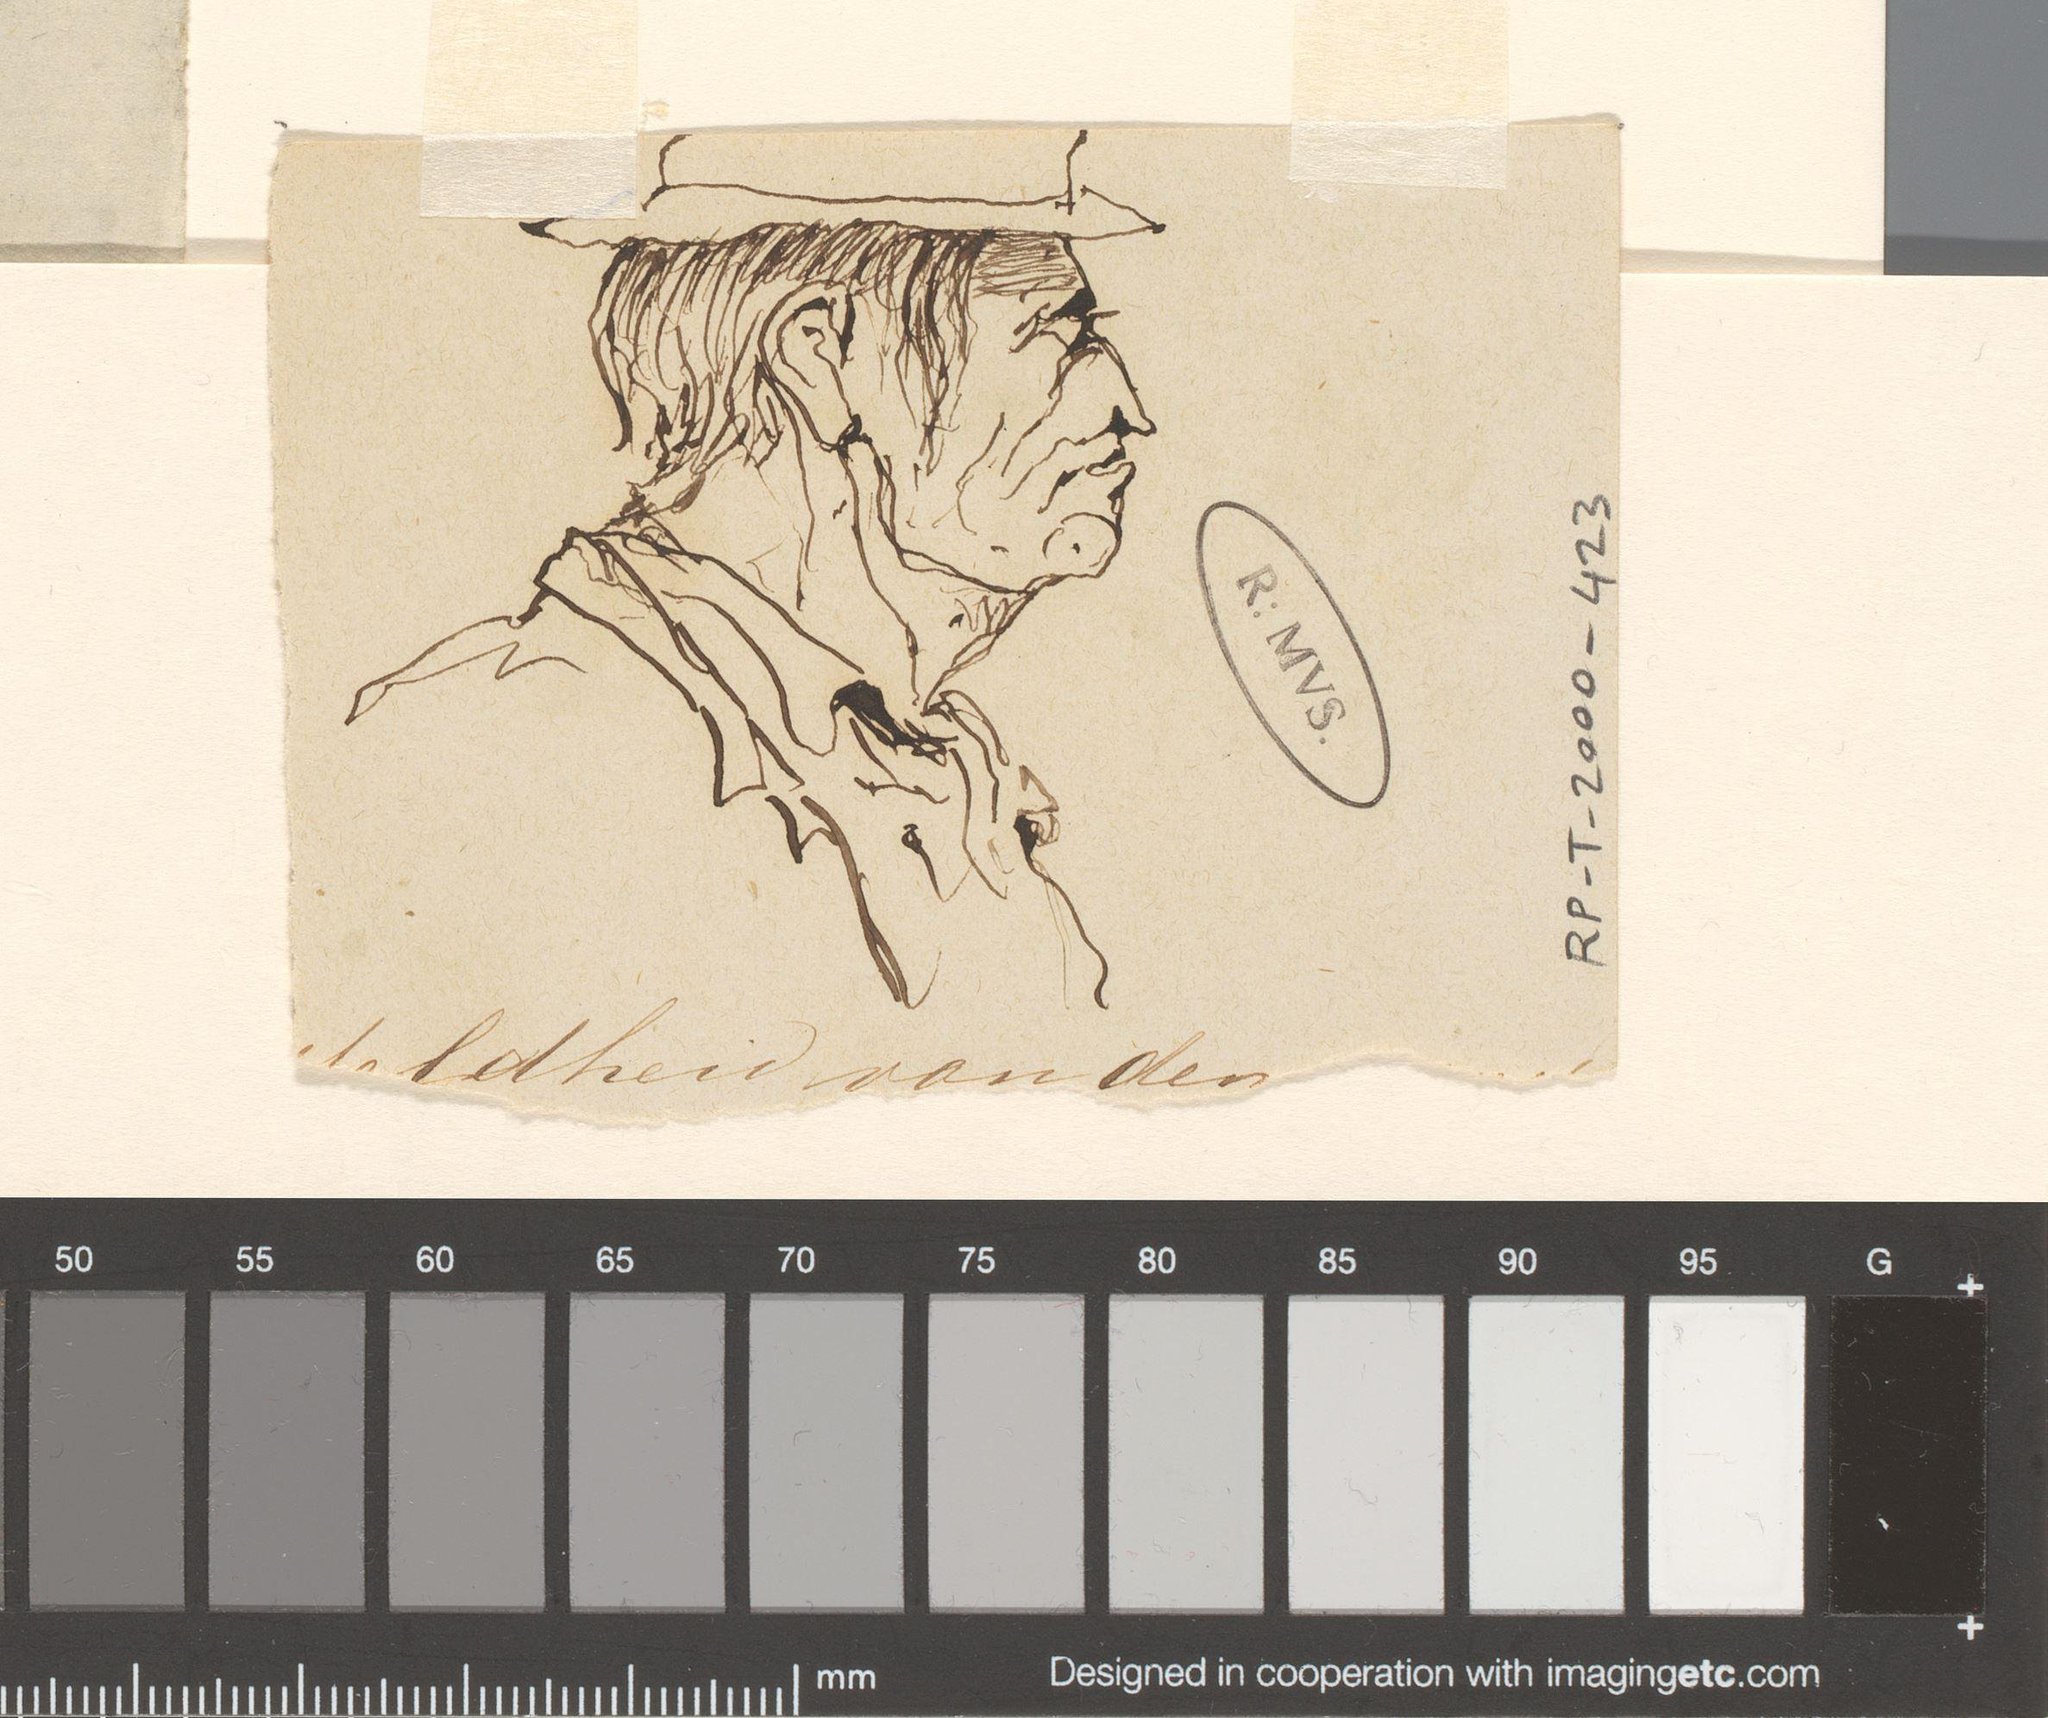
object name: drawing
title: Kop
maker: johannes tavenraat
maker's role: draughtsman, painter, print maker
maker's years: 1809-1881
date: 1840-1880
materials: ink, paper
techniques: pen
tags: caricatures (human types)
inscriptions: collector's mark: Lugt 2228